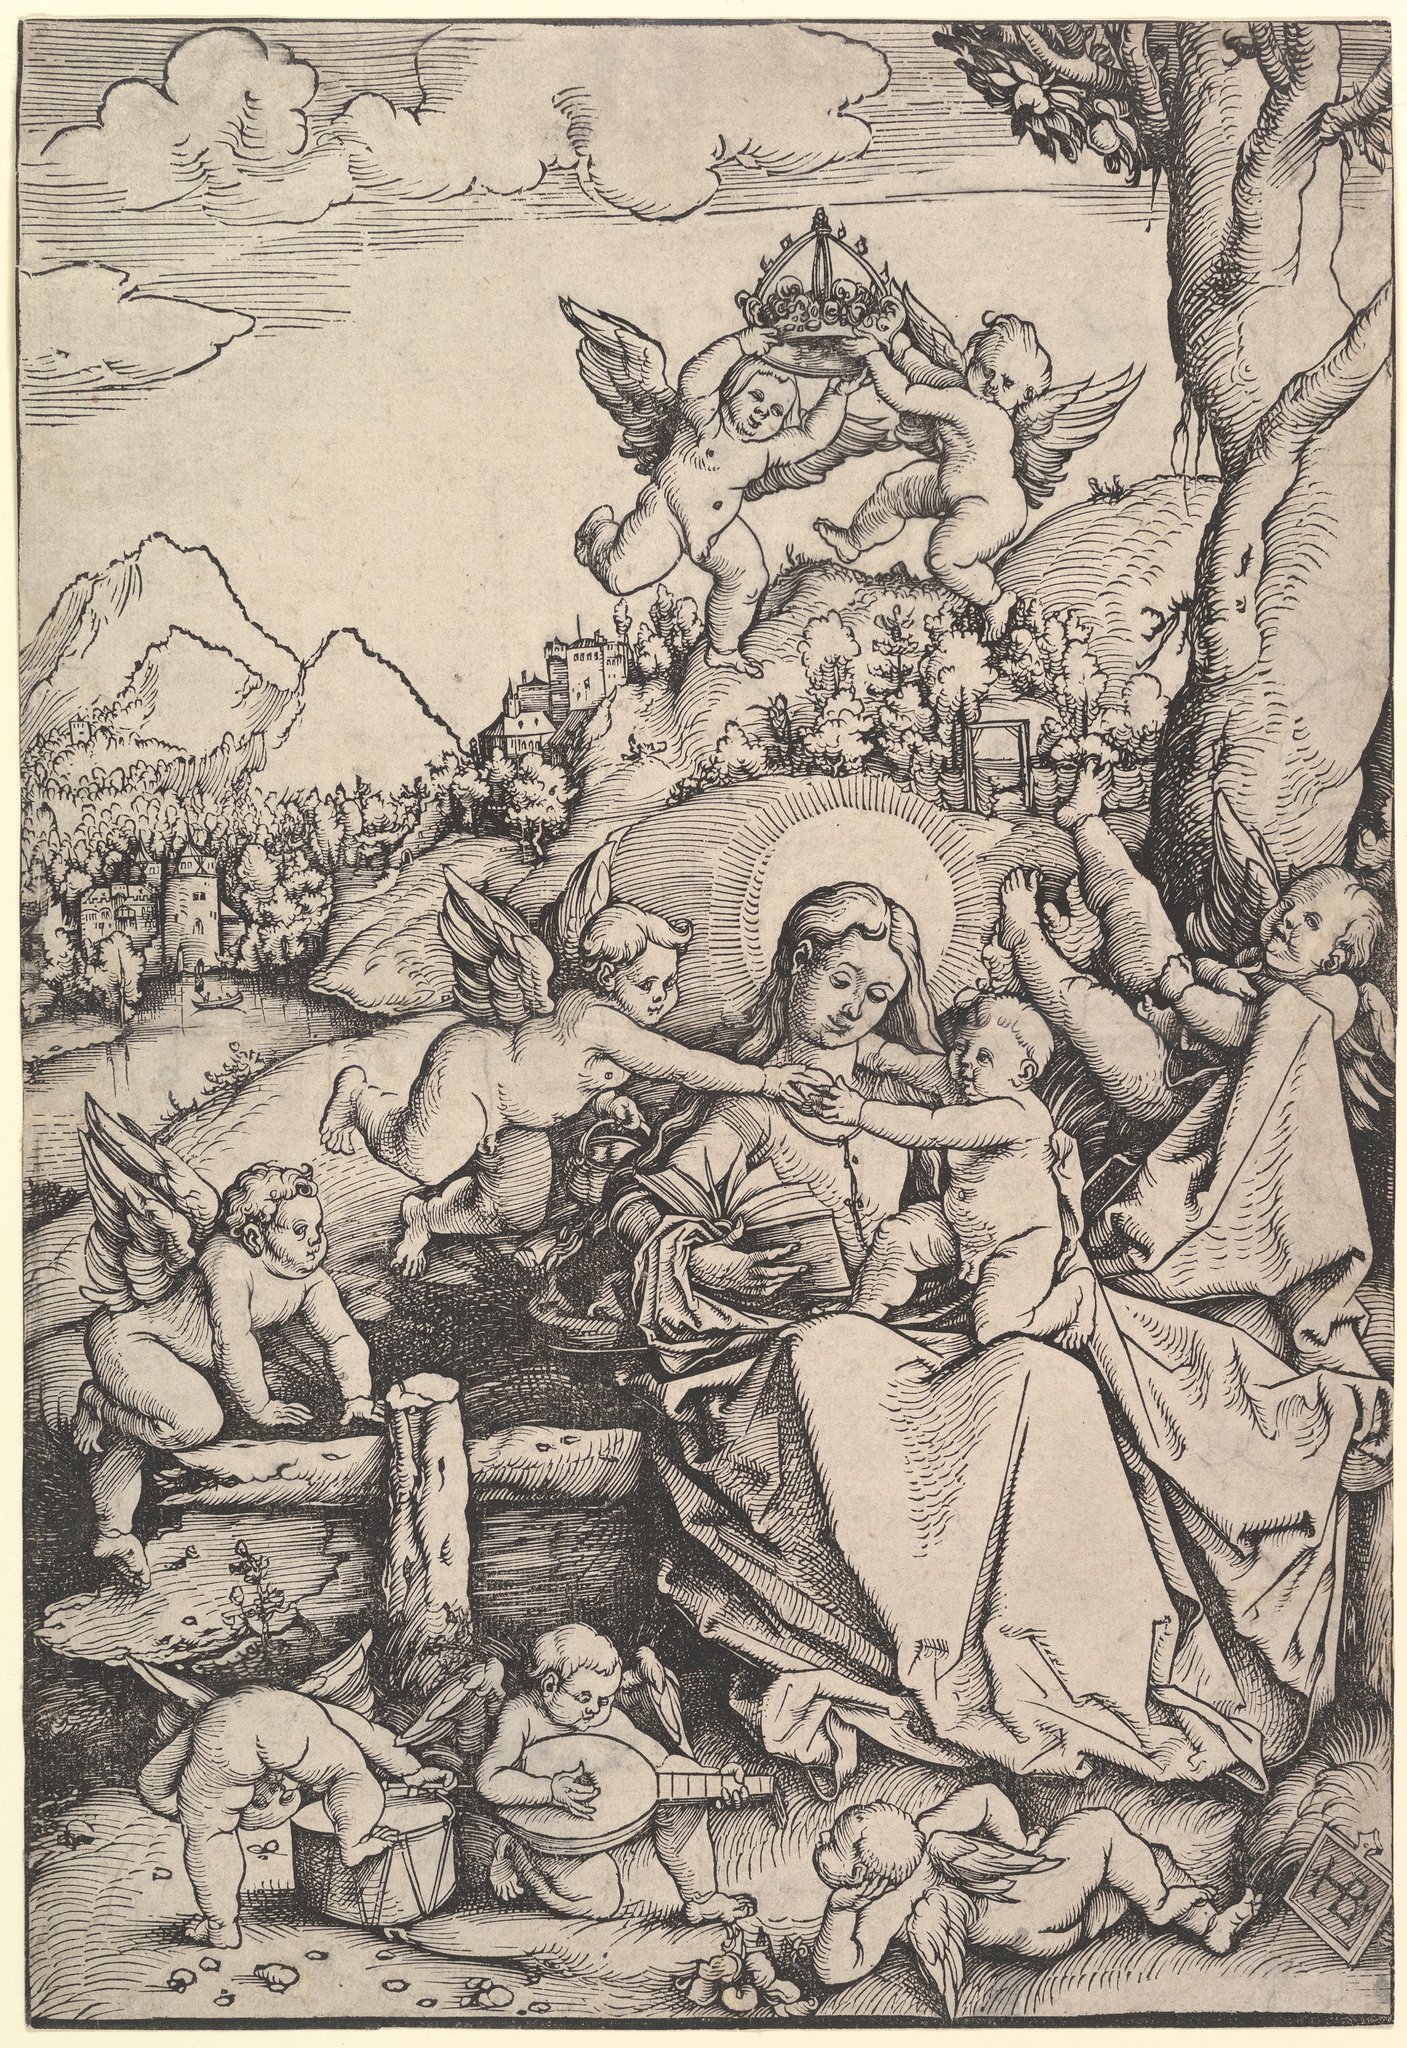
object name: print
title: The Virgin and Child with Eight Angels in a Landscape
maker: hans baldung (called hans baldung grien)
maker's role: artist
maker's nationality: german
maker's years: 1484-1545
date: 1511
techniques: woodcut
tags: musical instruments,angels,madonna and child